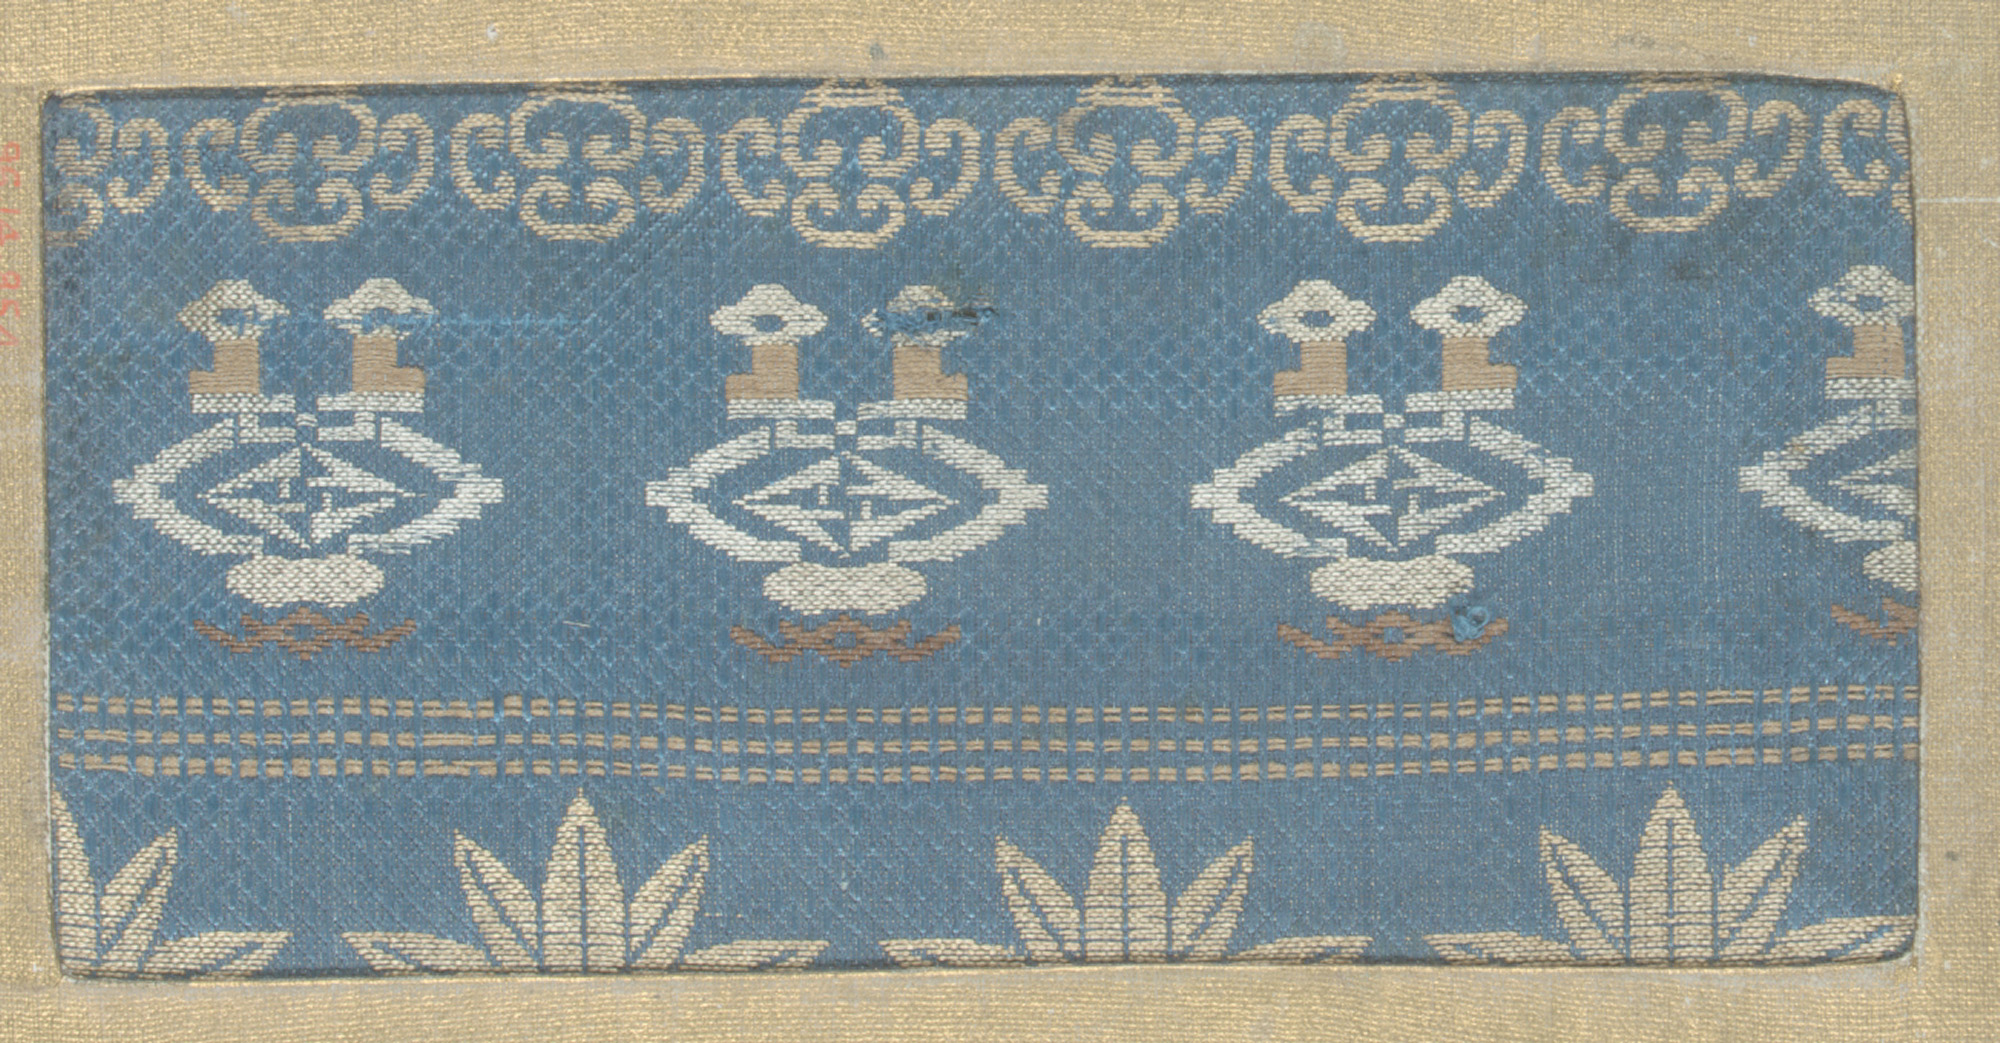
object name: piece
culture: japanese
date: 1701-1900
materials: silk